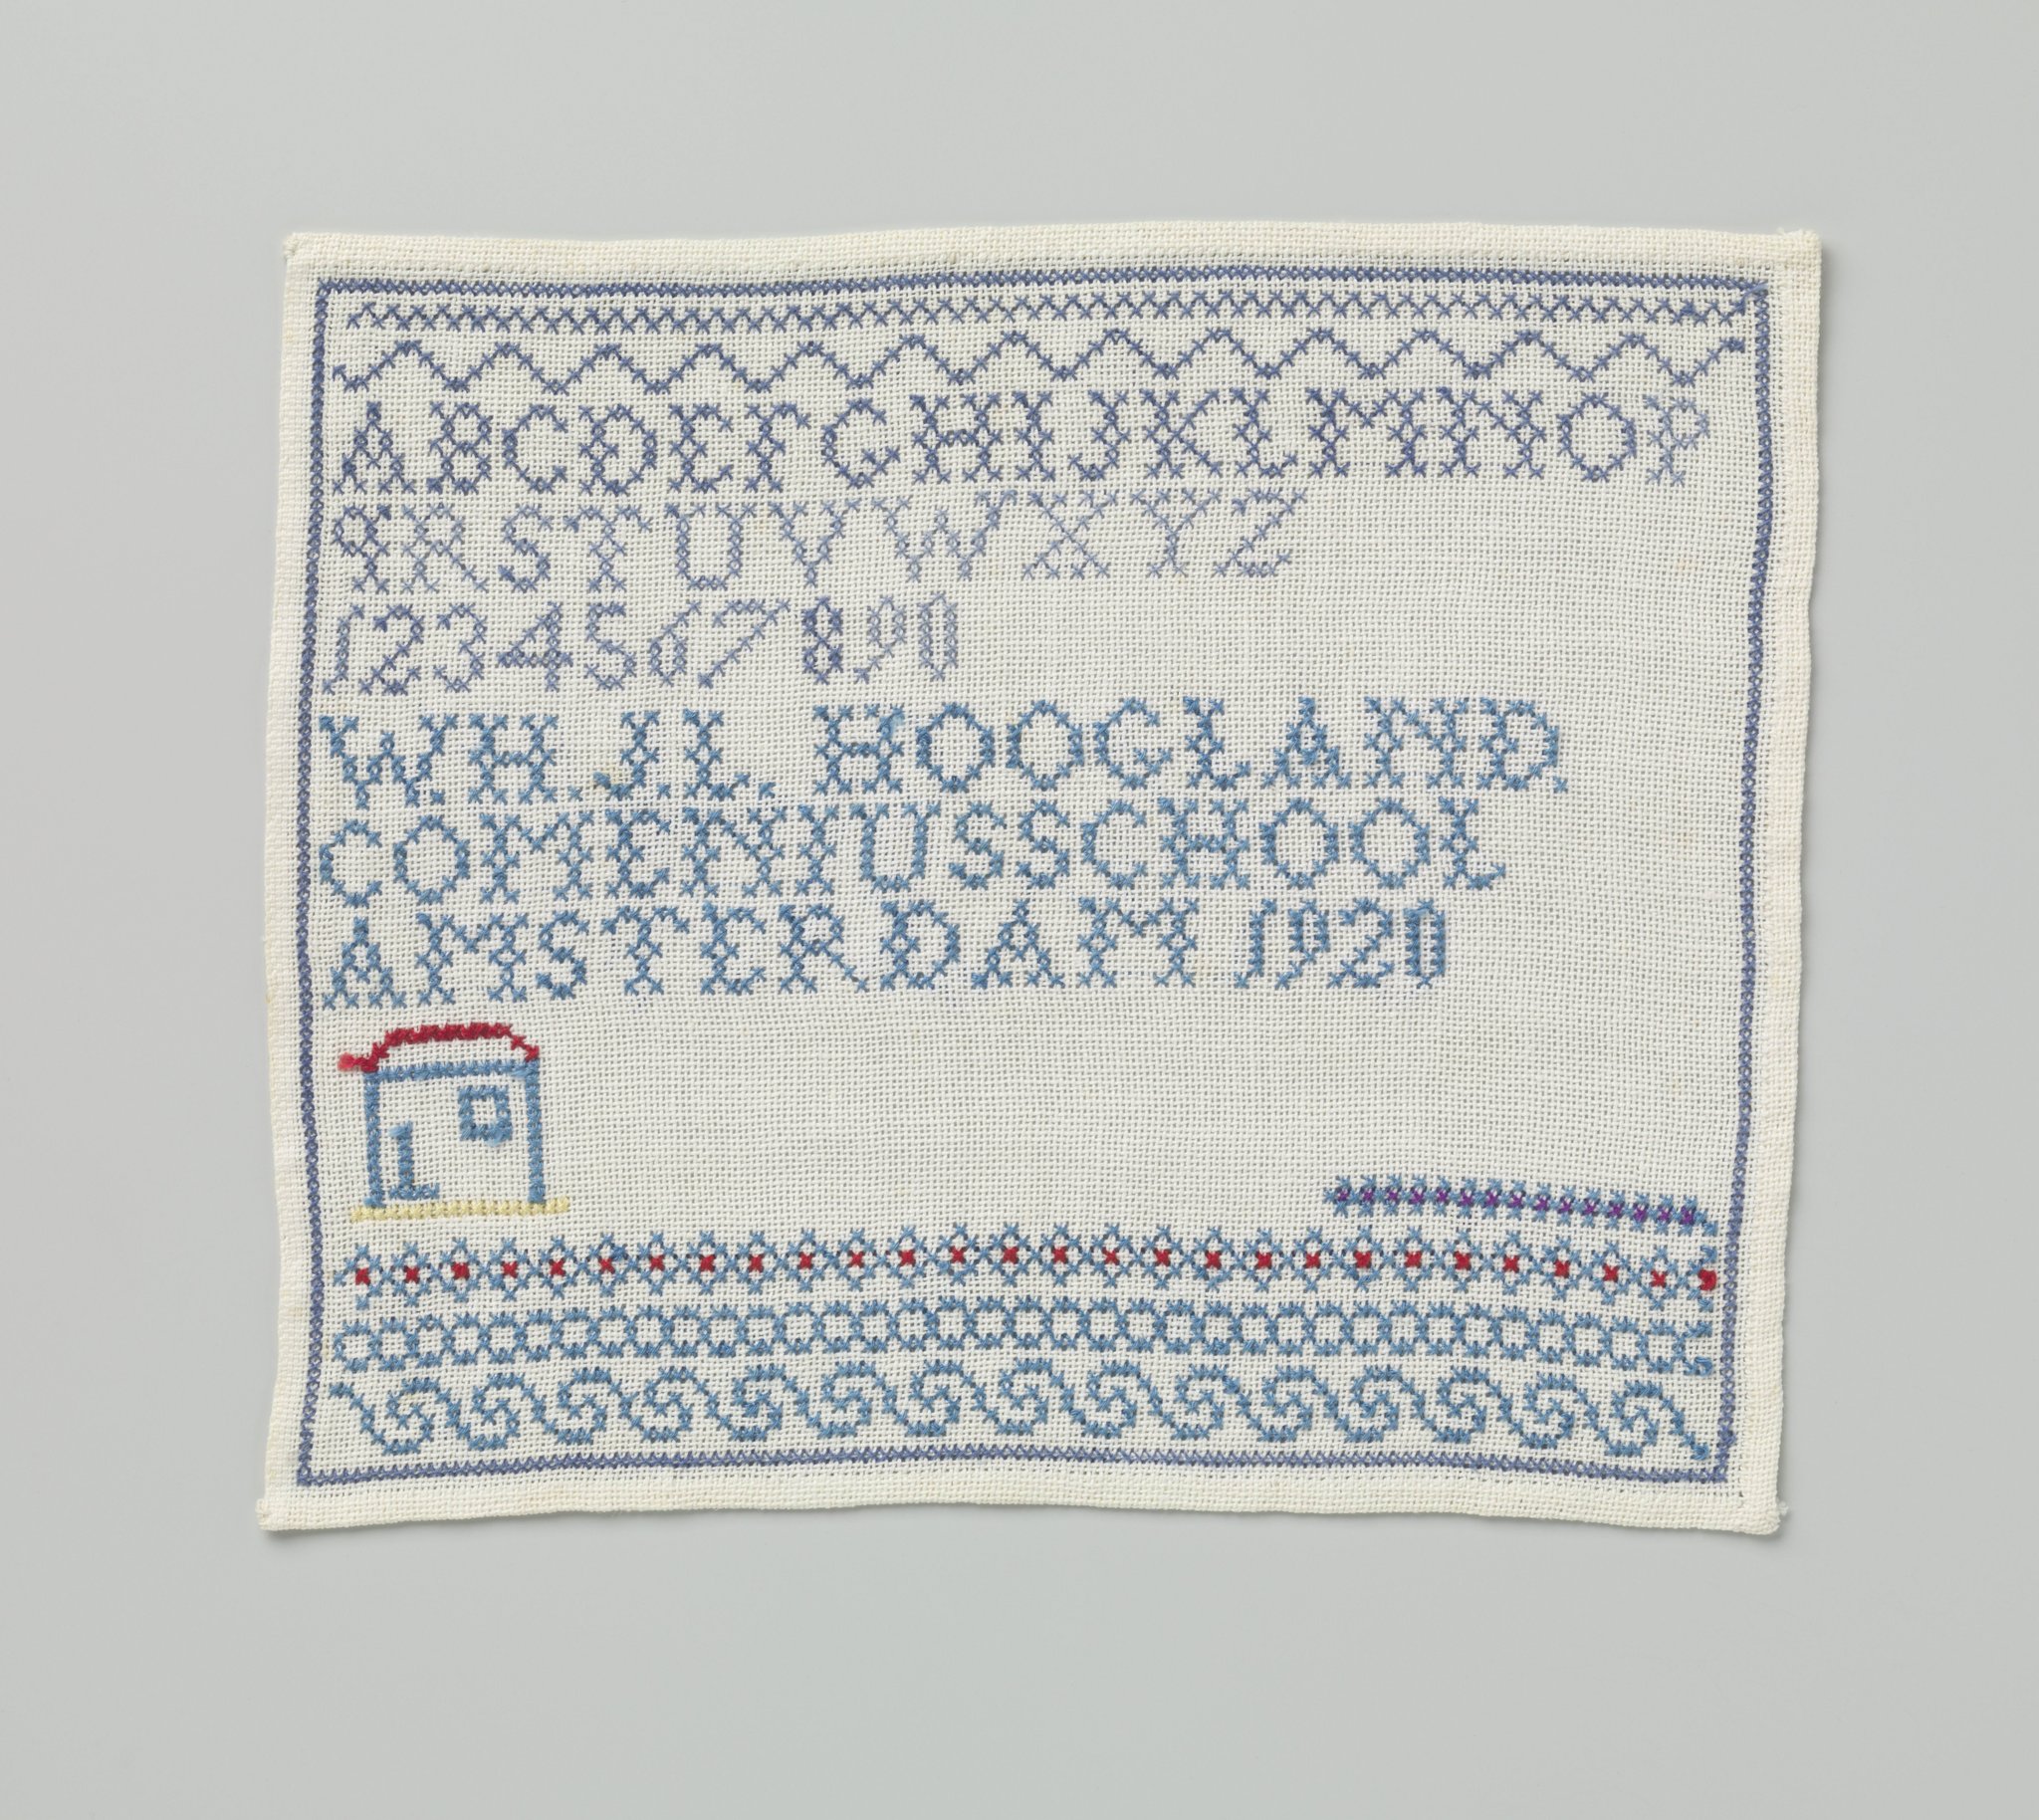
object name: merkdoek, merklap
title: Merklap van veelkleurige katoen op katoen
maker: w.h.j.l. hoogland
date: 1920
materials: cotton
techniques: embroidered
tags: w.h.j.l. hoogland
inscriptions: date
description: Merklap van katoen op katoen. Het borduurwerk heeft de tekst W.H. J.L Hoogland en de datering 1920.